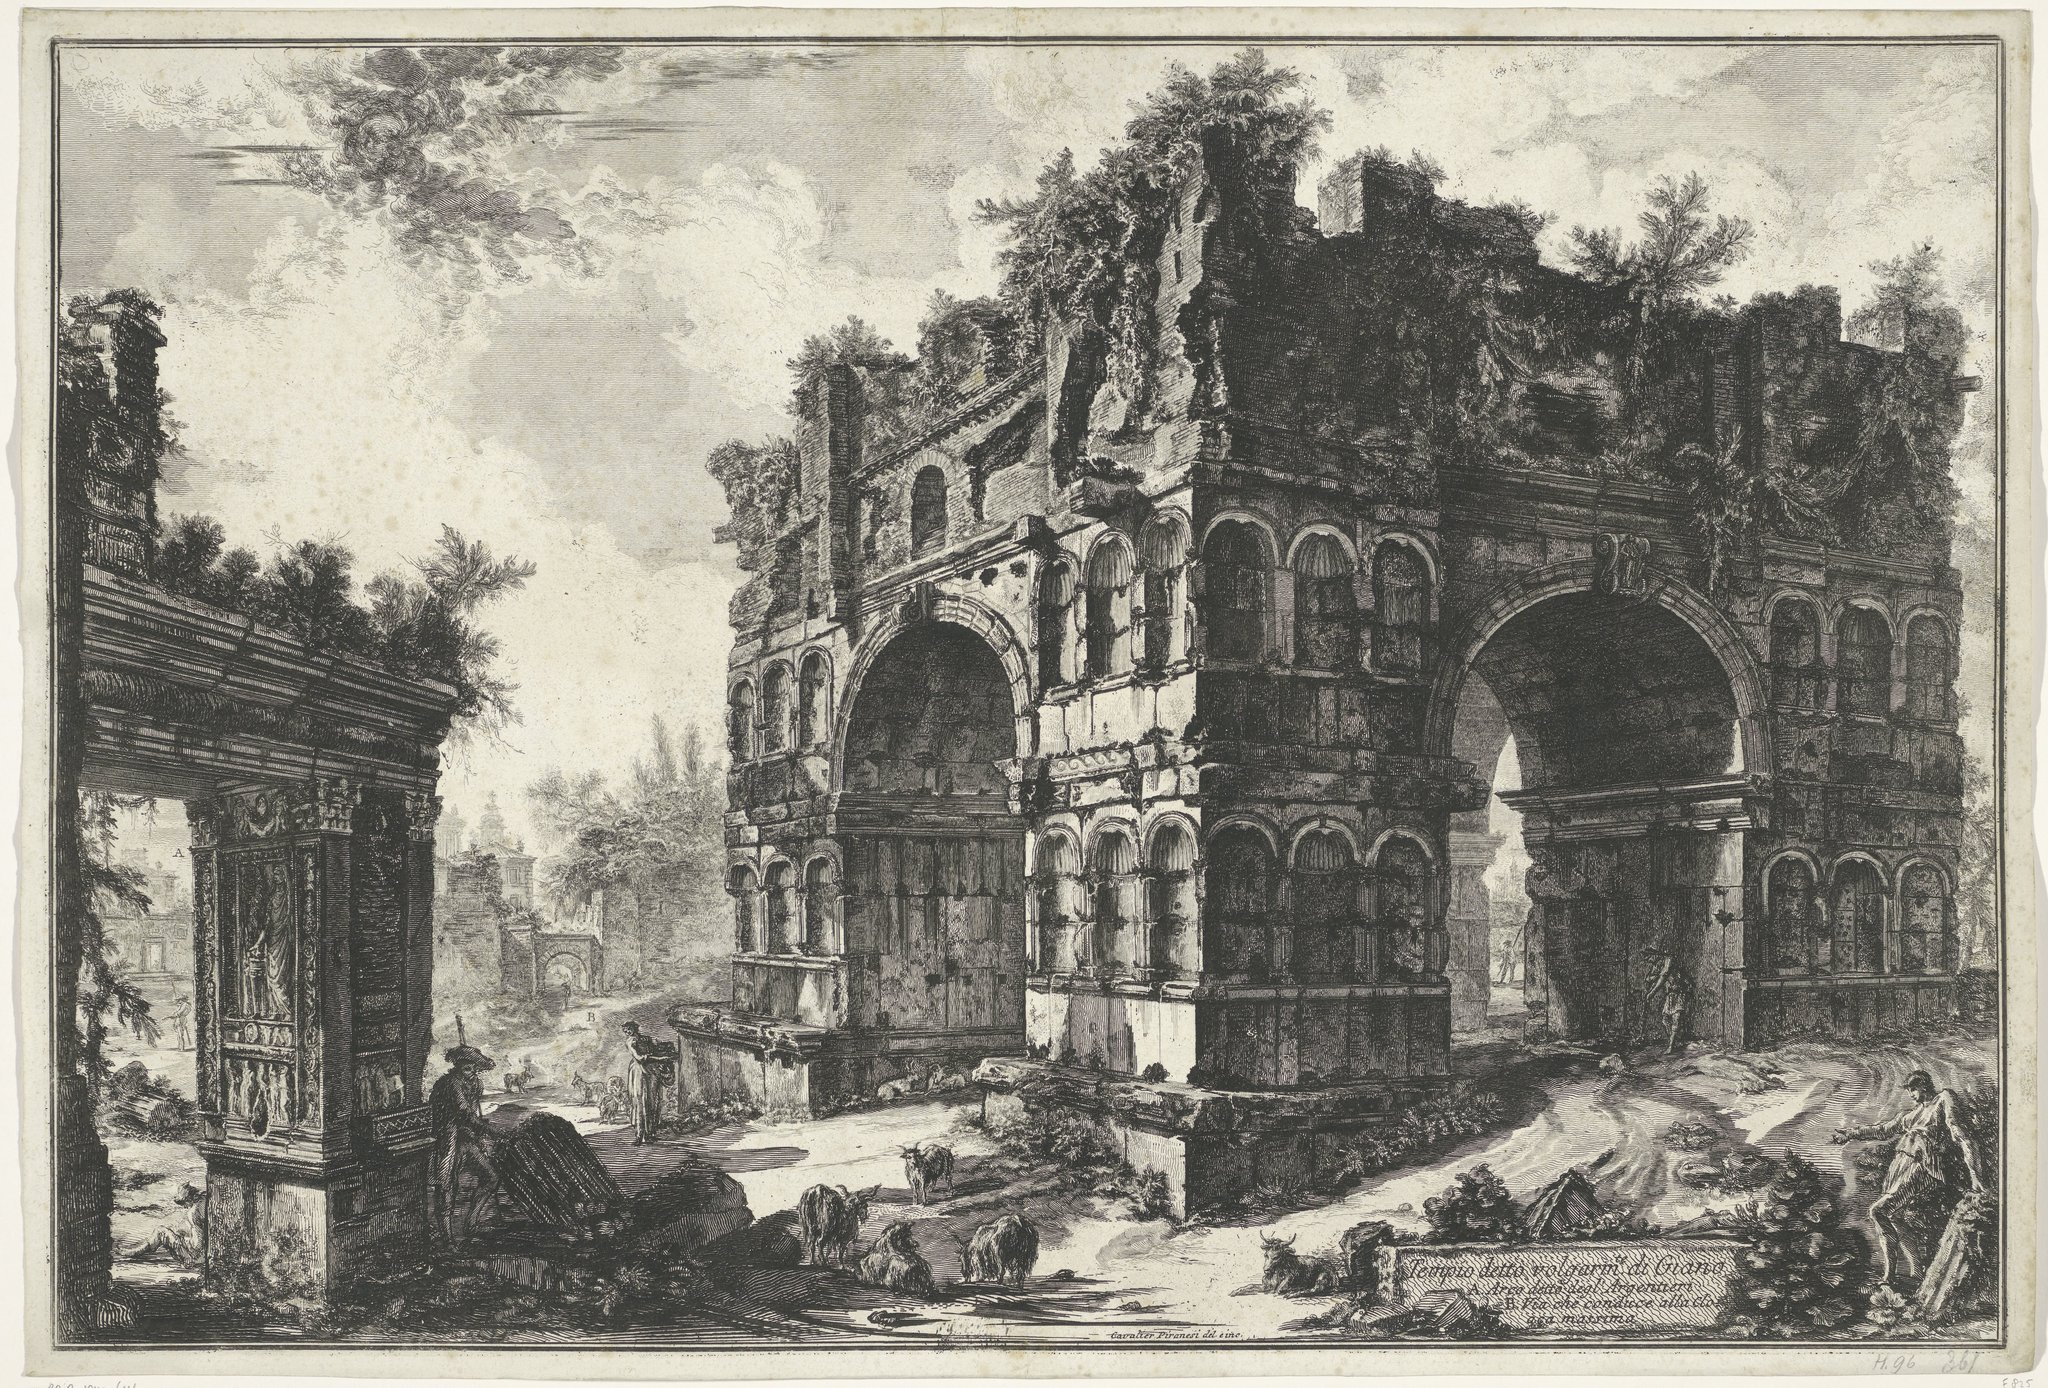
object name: print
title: Gezichten op Rome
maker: giovanni battista piranesi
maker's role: designer, draughtsman, print maker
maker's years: 1720-1778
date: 1748-1778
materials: paper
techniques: etching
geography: rome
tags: triumphal arch, landscape with ruins, rome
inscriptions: collector's mark: Lugt 2228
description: Deze prent maakt deel uit van de serie 'Vedute di Roma'. Piranesi werkte aan deze 135 platen tellende serie tussen 1748 en zijn dood in 1778. Francesco Piranesi voegde later nog twee prenten toe aan de reeks van zijn vader.